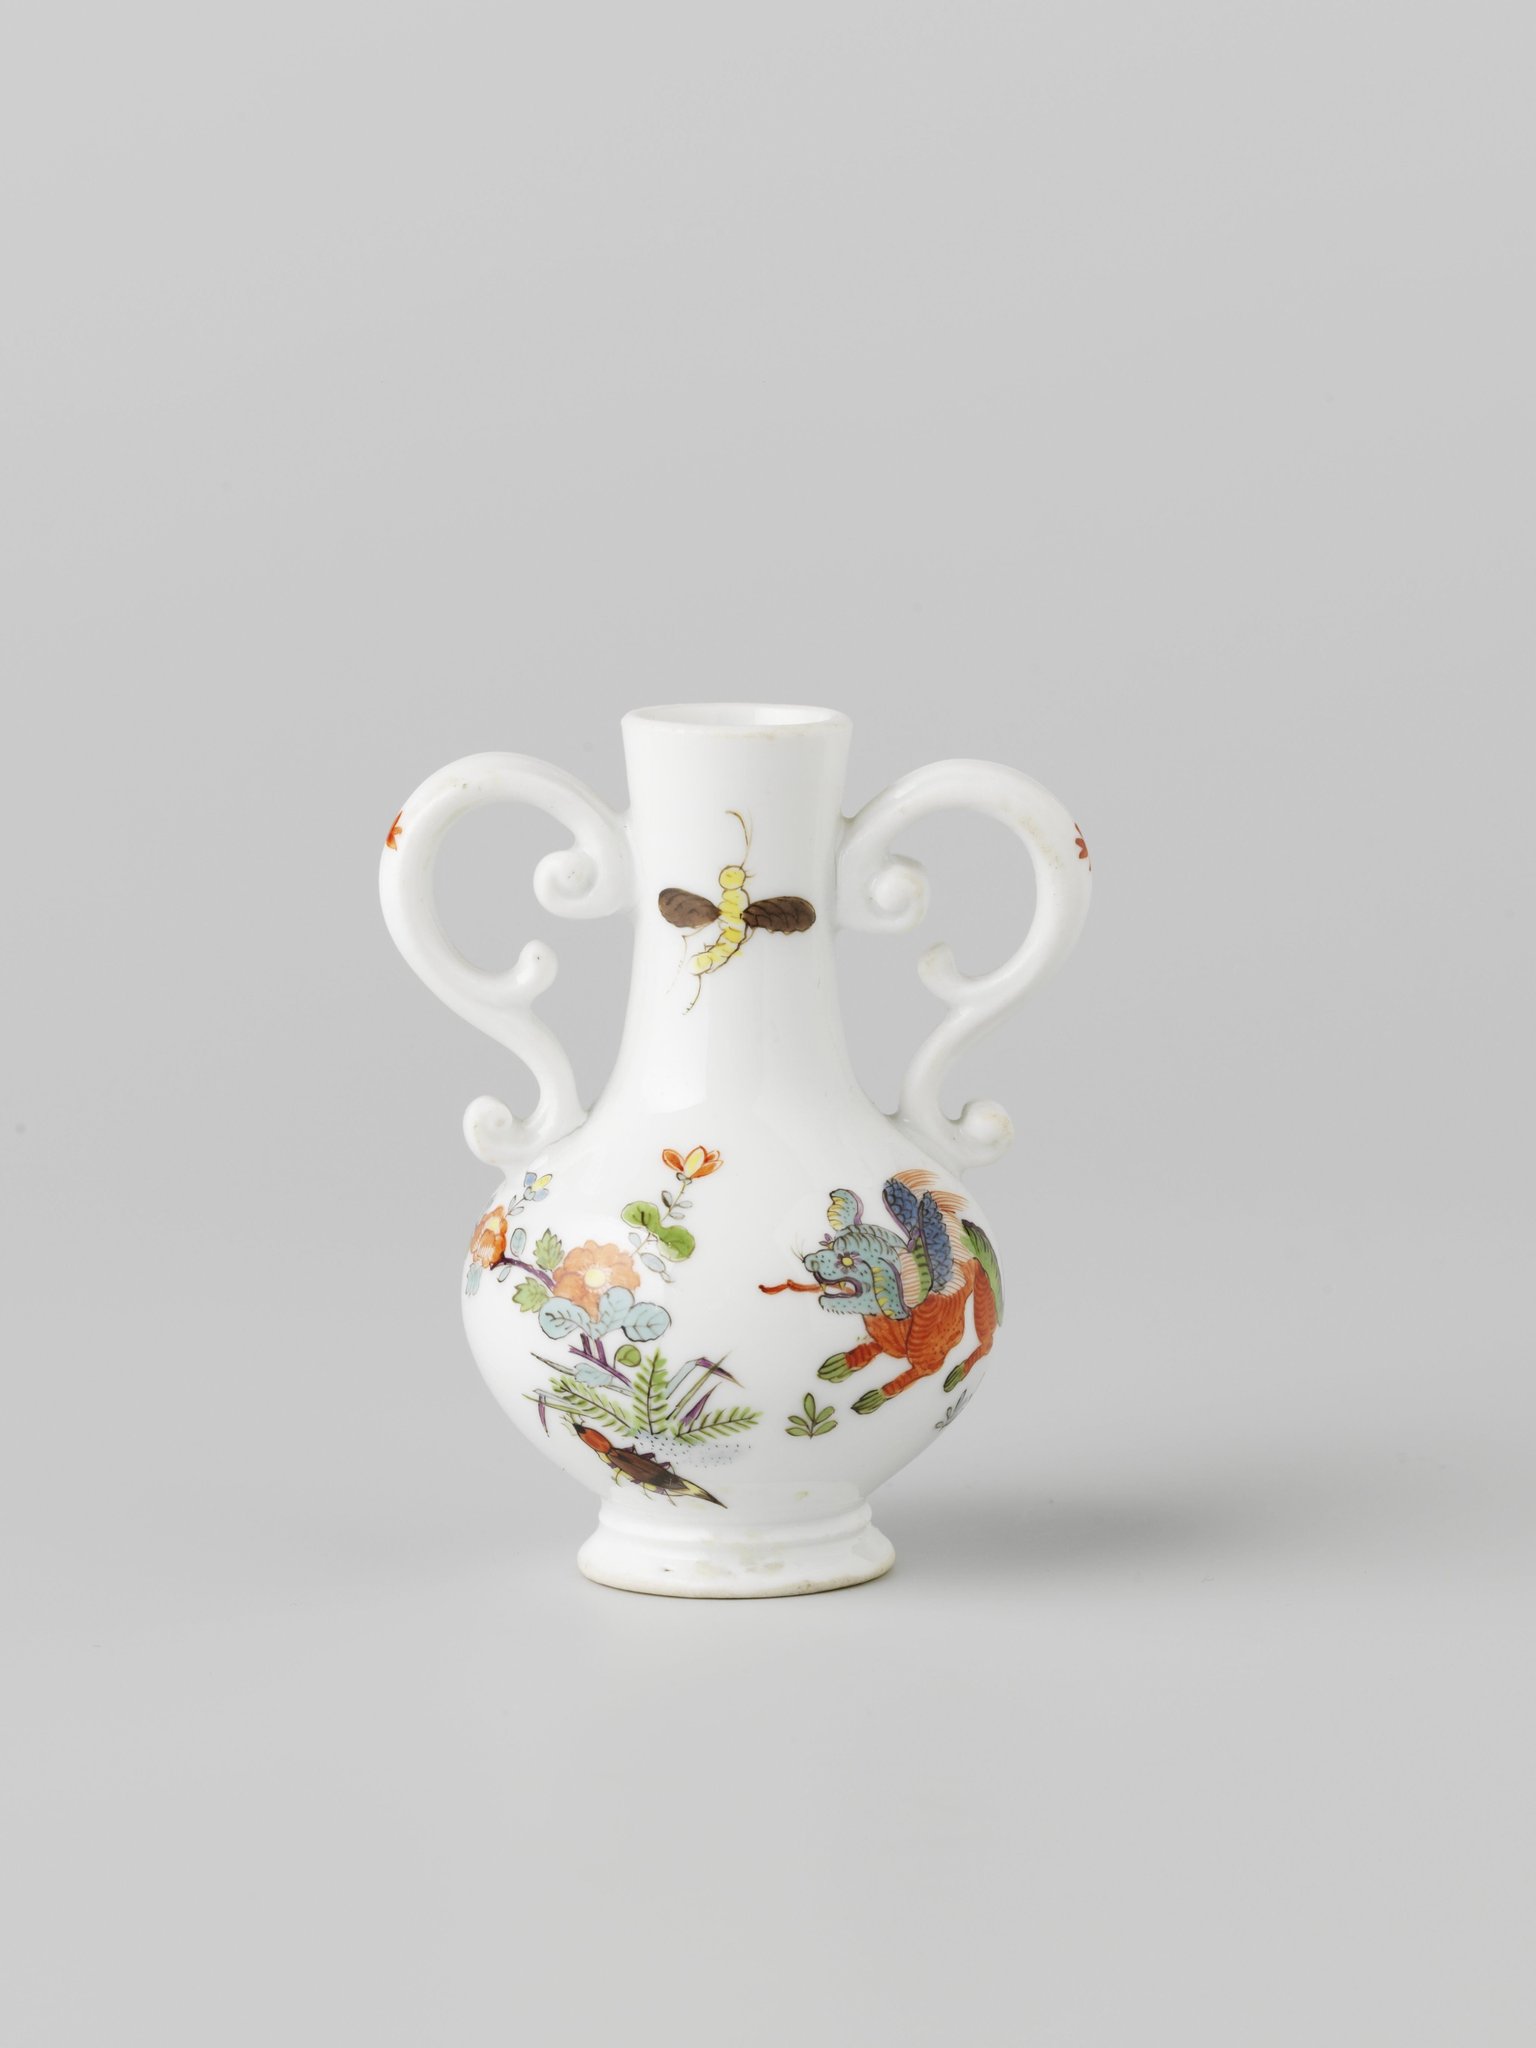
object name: decoratief object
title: Fles met twee oren, veelkleurig beschilderd met een Kakiemon-decor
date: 1735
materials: porcelain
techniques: painted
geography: meissen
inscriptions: factory mark, mark: ‘Z’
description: Two miniature vases. Meissen, c. 1730 - 1740.